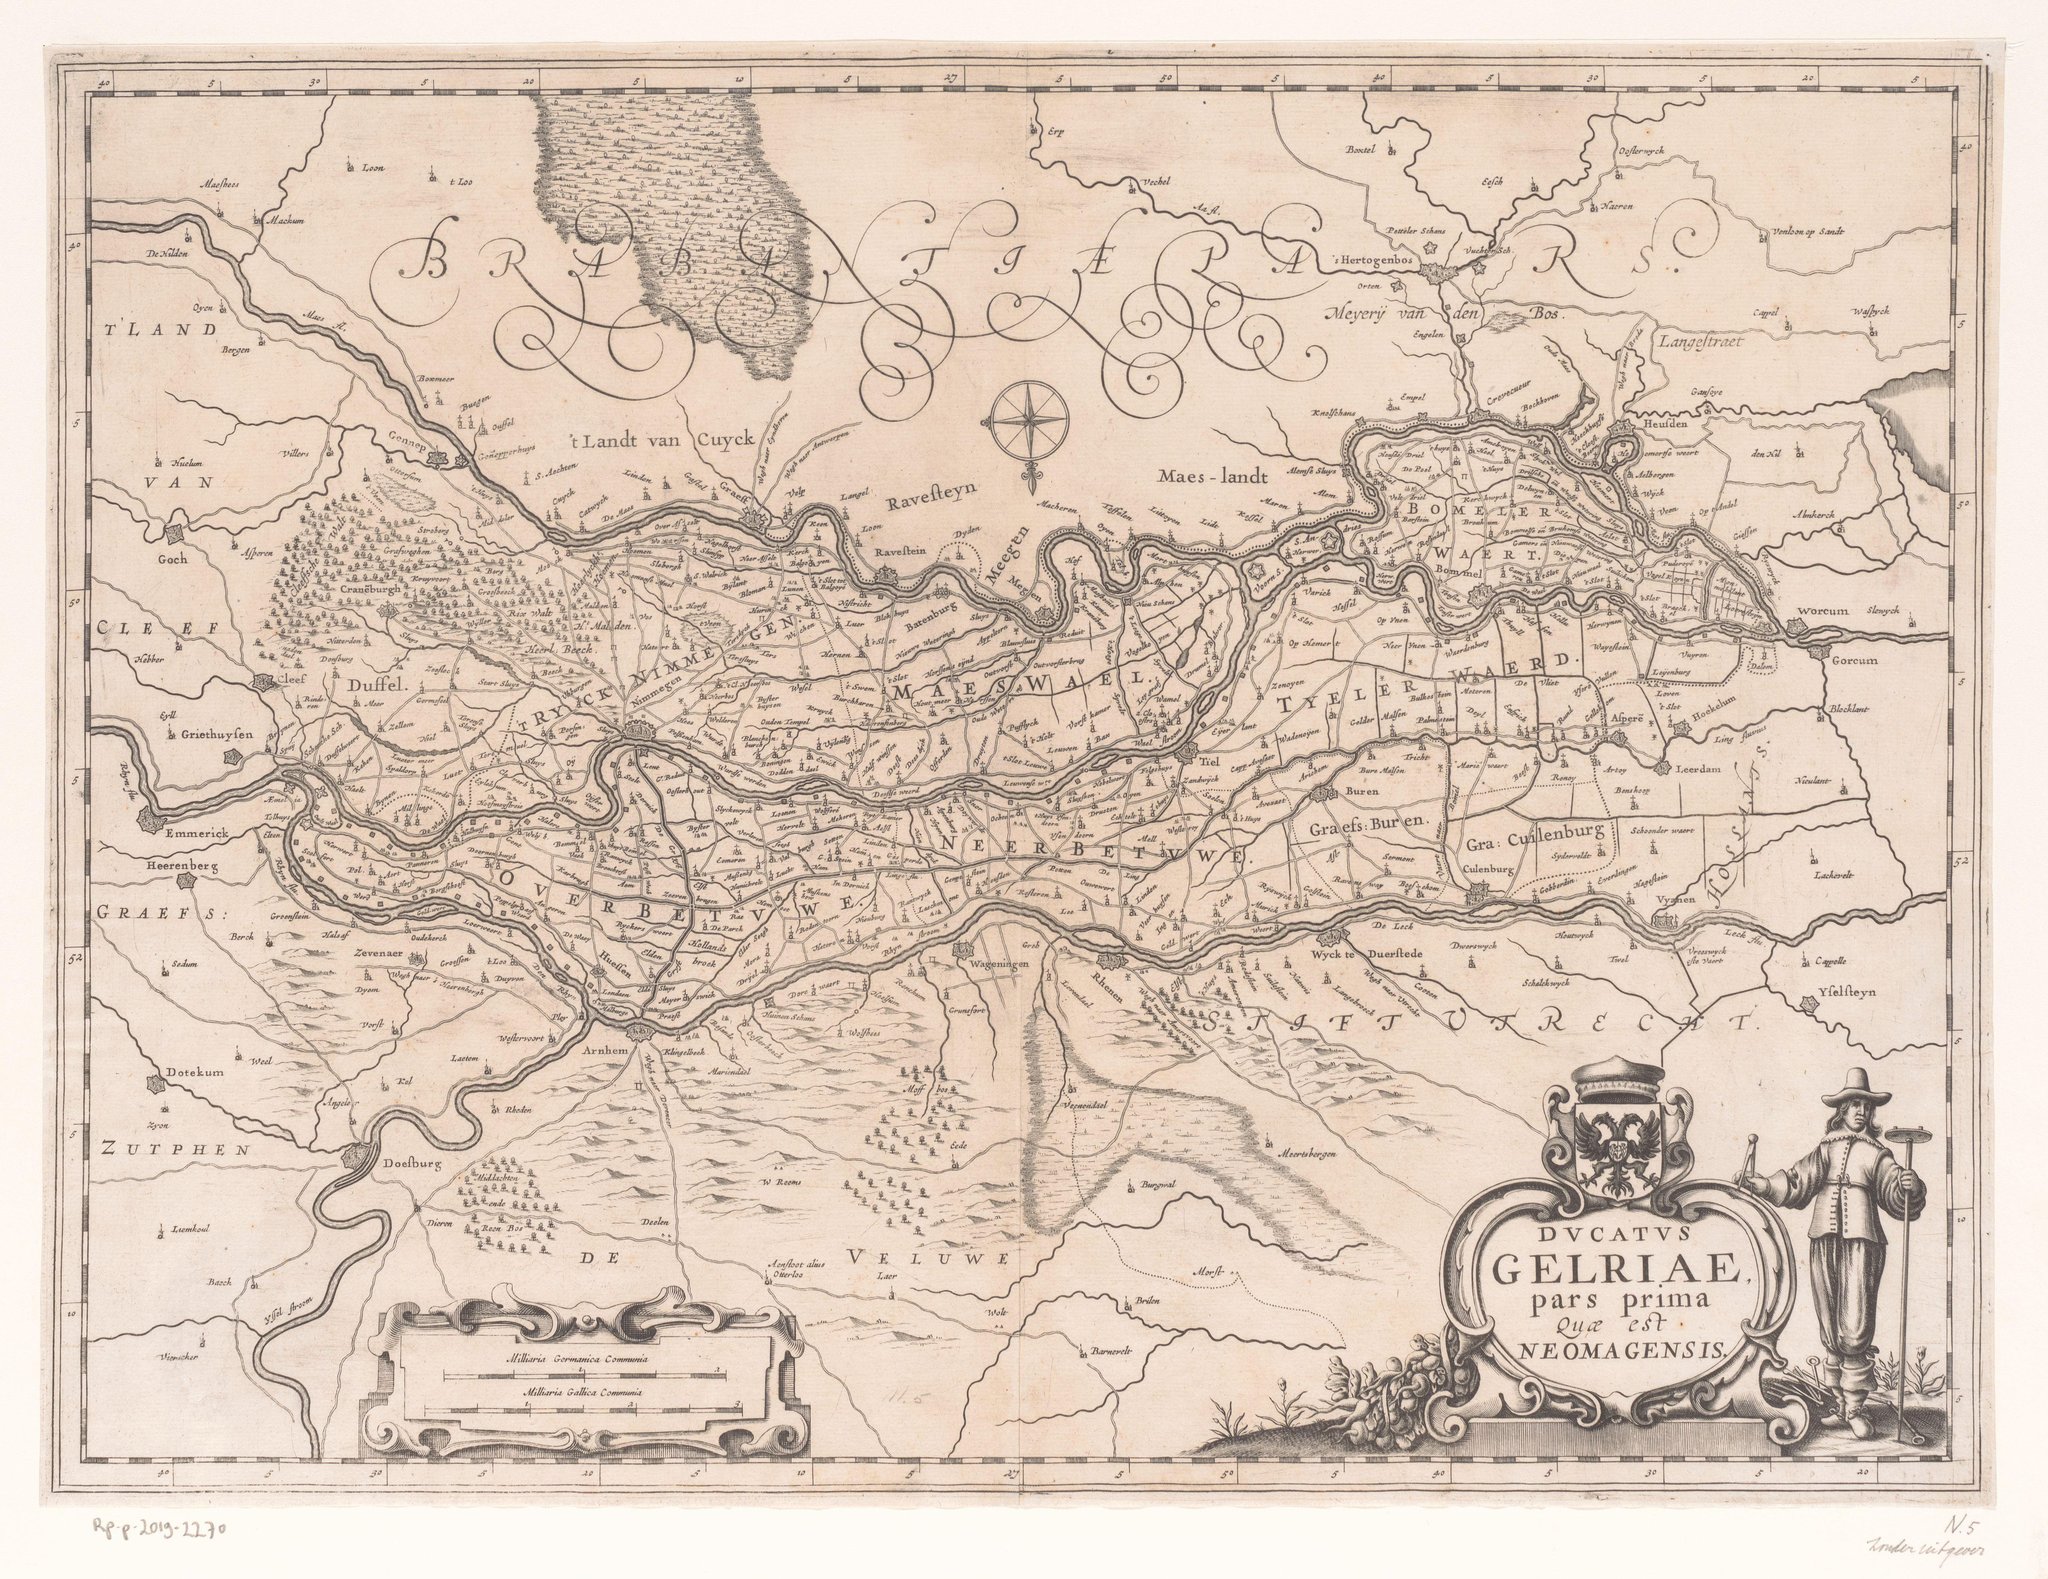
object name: map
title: Kaart van het Kwartier van Nijmegen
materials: paper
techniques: engraving, etching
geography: amsterdam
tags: coat of arms (as symbol of the state, etc.) (+ city; municipal), maps of separate countries or regions, nijmegen, gelderland, guelders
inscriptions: collector's mark: Lugt 2228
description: Rechtsonder de titelcartouche, met bovenin het wapen van Nijmegen. Linksonder een cartouche met twee schaalstokken: 2 Milliaria Germanica Communis / 3 Milliaria Gallica Communis. De kaart is voorzien van een zoekrooster en een gradenverdeling langs de randen.